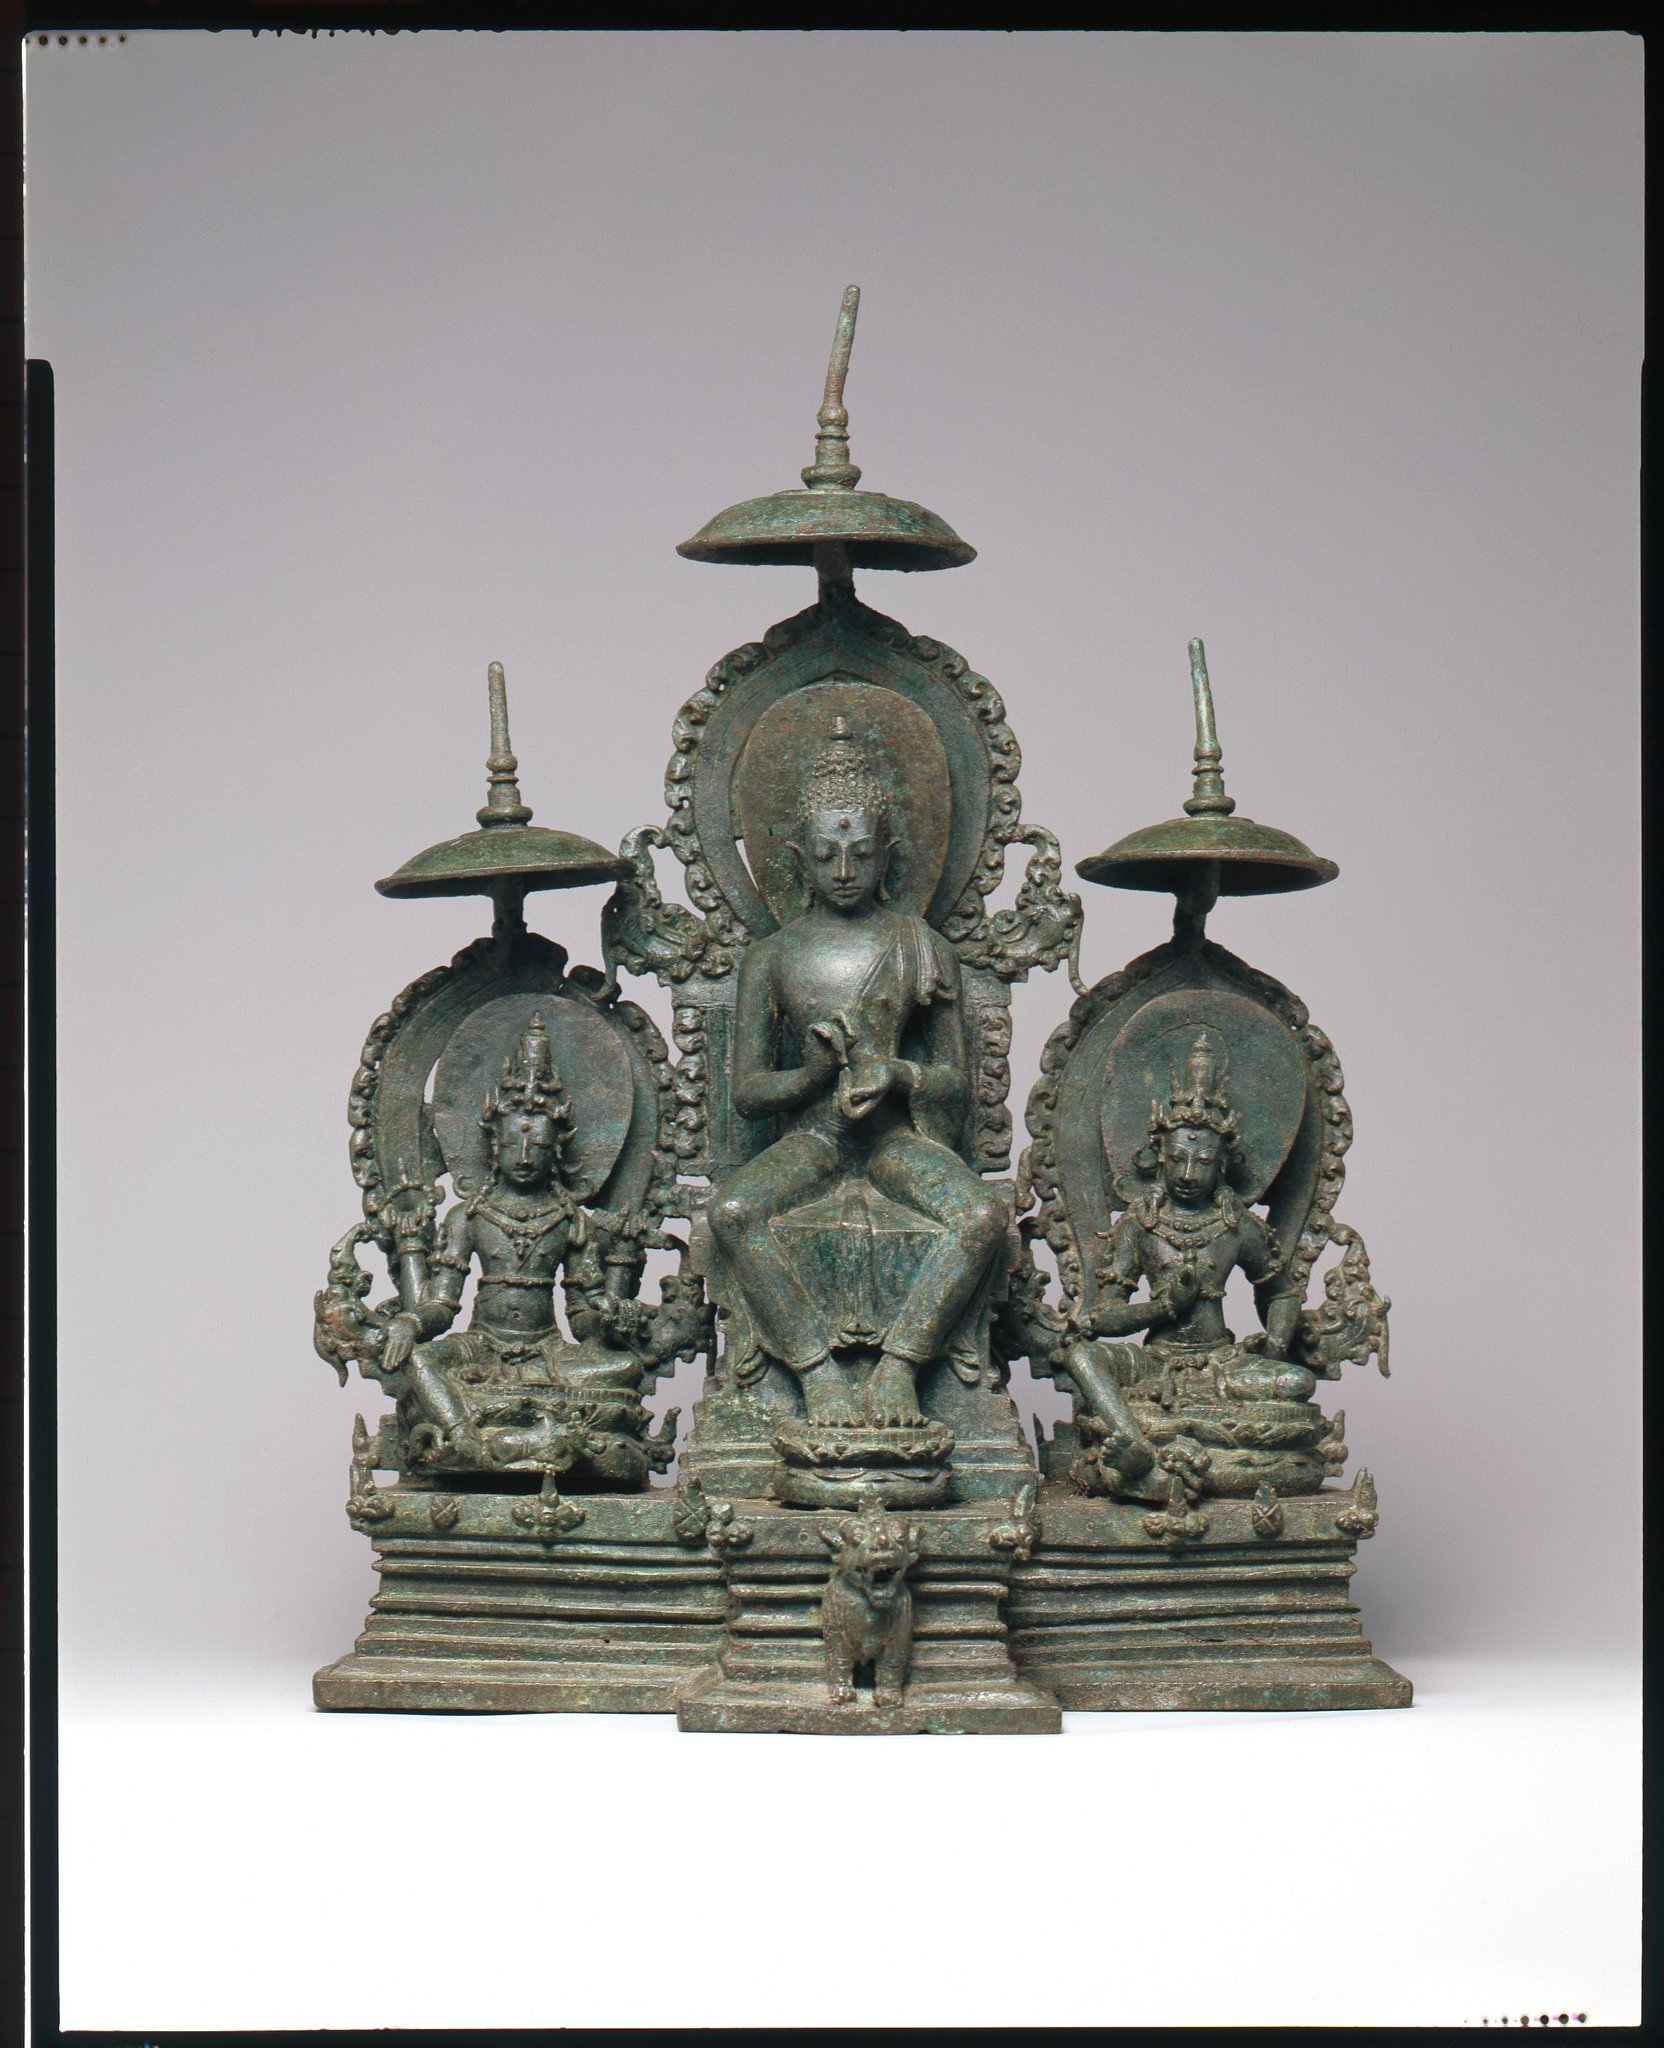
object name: group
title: Enthroned Buddha Attended by the Bodhisattvas Avalokiteshvara and Vajrapani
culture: indonesian, javanese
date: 951-1000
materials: bronze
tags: avalokiteshvara,buddha,shakyamuni,vajrapani